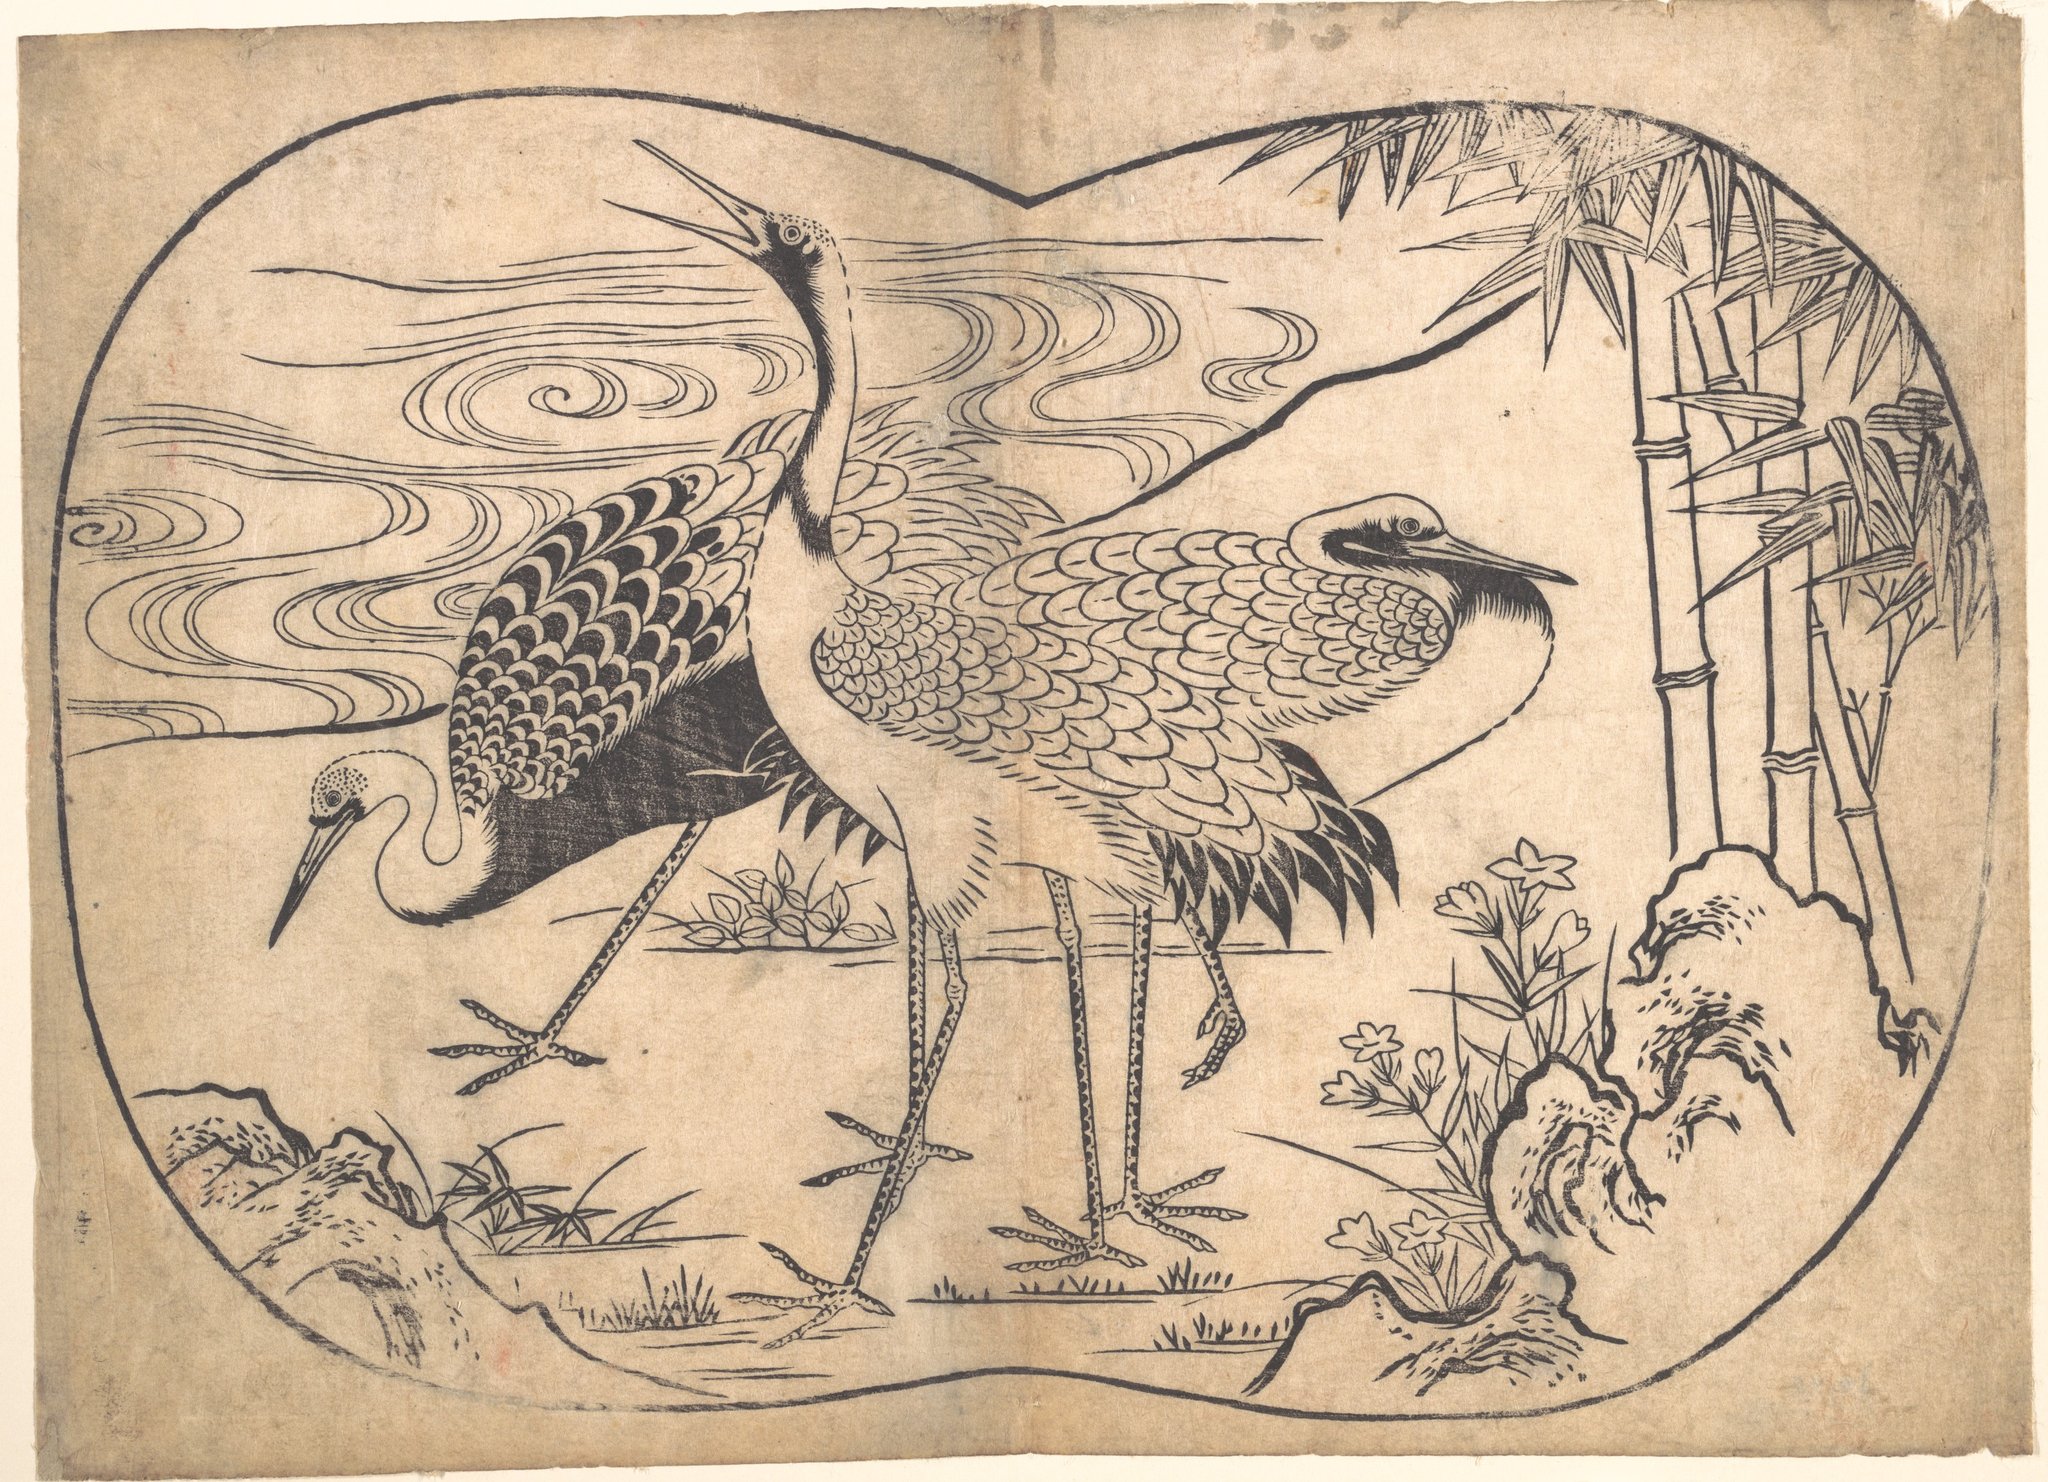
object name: print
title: Cranes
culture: japanese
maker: hishikawa moronobu 菱川師宣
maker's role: artist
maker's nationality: japanese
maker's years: 1618-1694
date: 1615-1868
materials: ink, paper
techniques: woodblock print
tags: cranes,bamboo,leaves